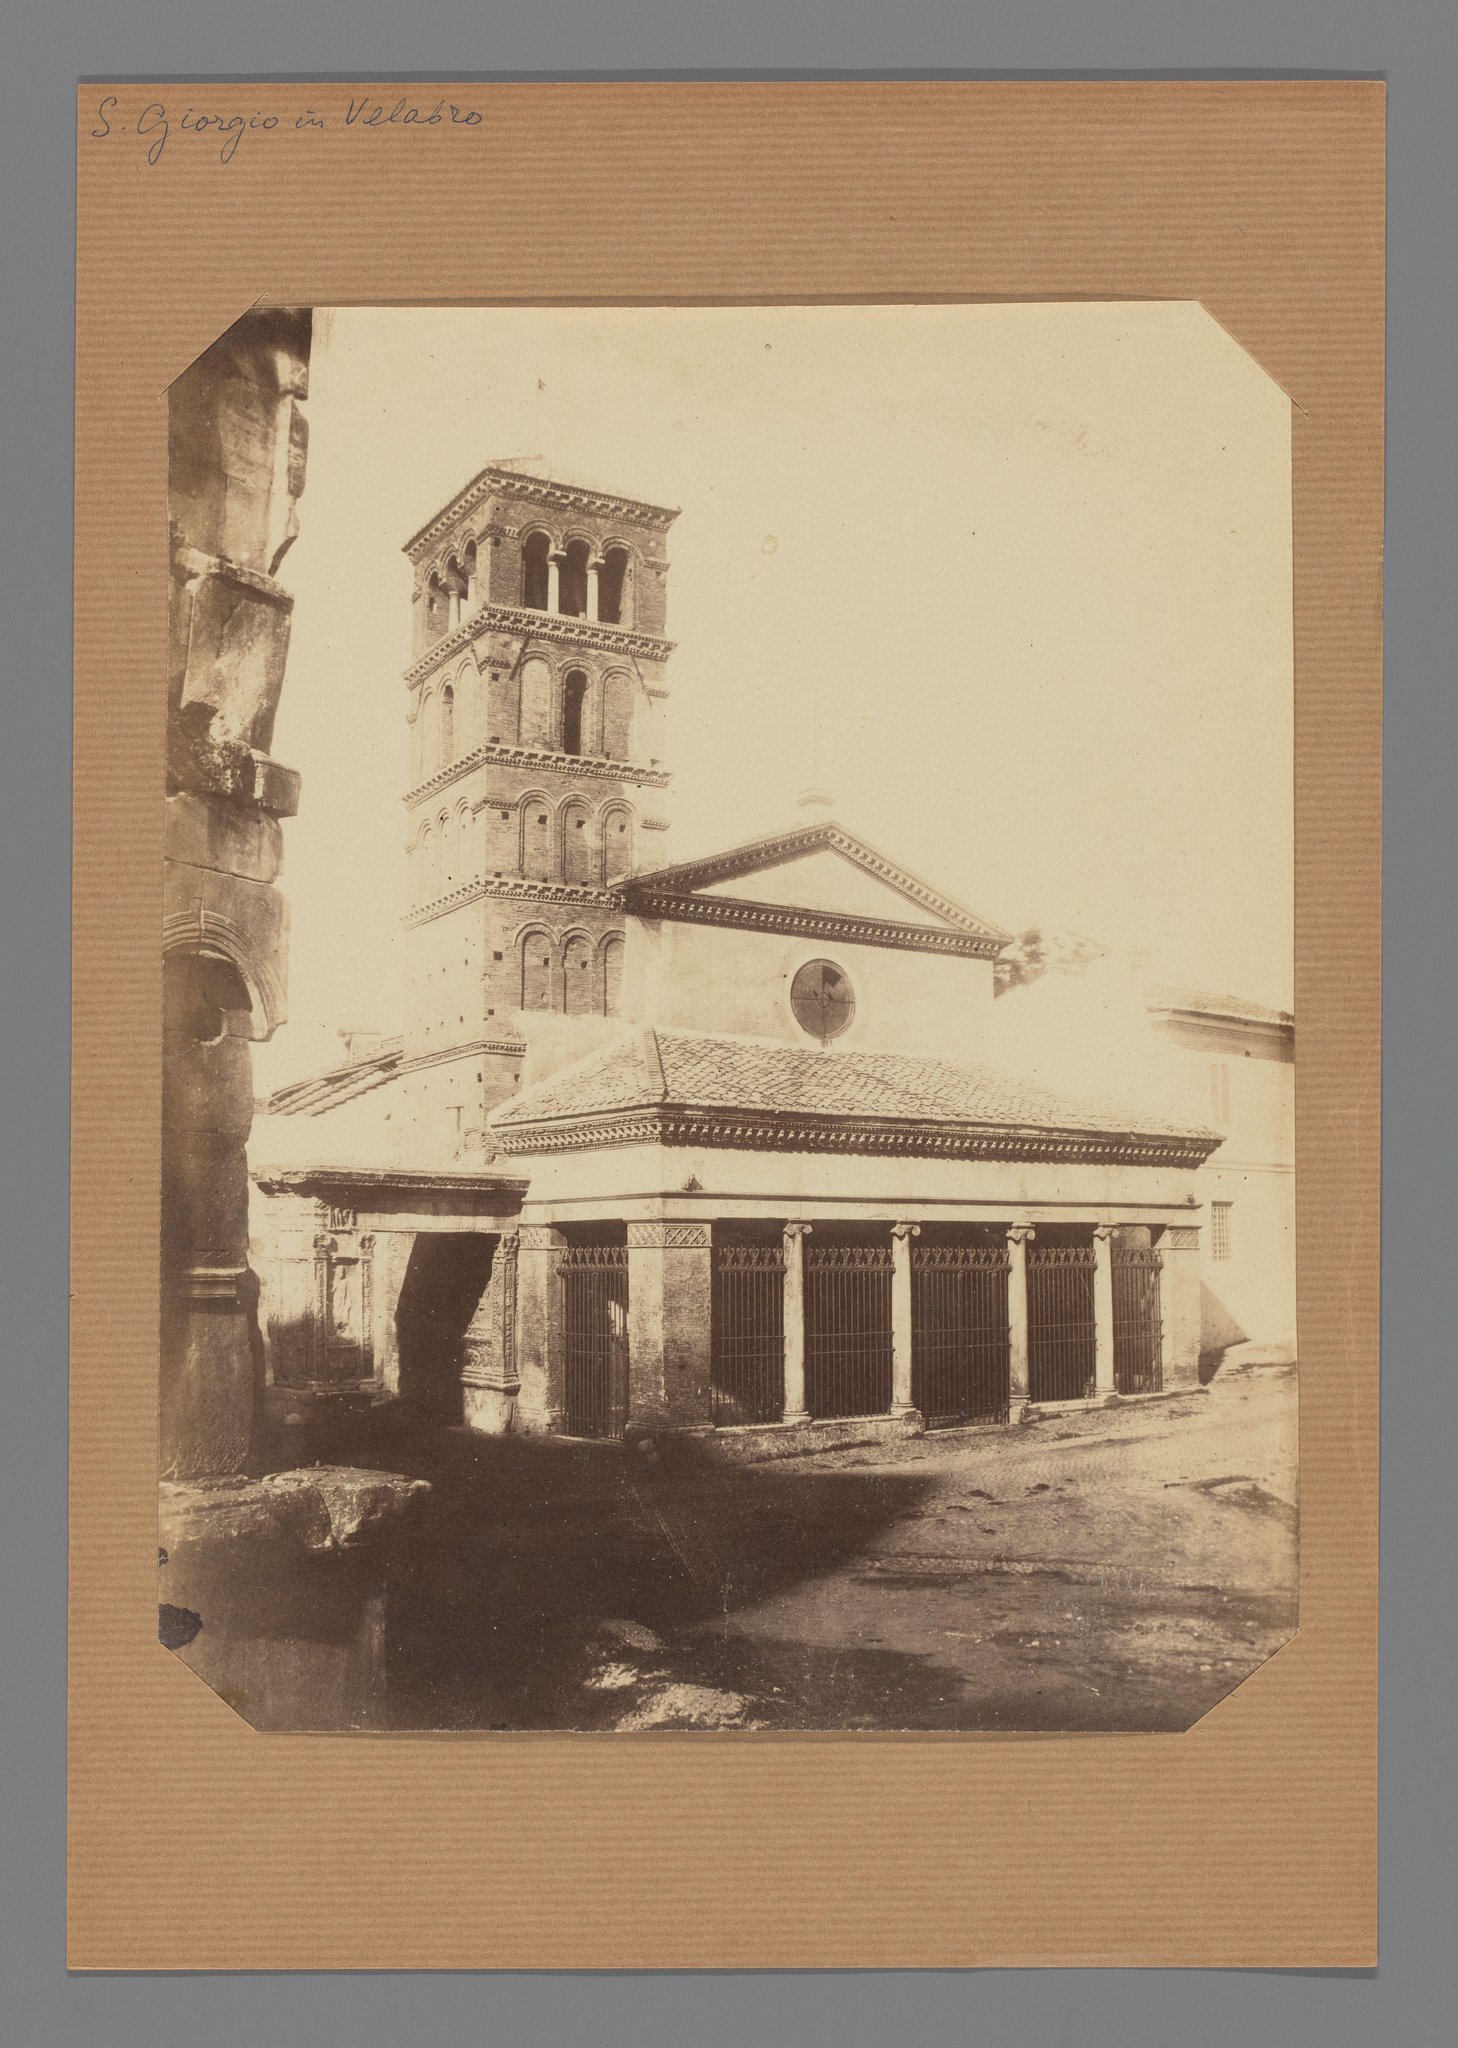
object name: photograph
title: S. Giorgio in Velabro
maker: Anonymous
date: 1850-1899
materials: paper, photographic support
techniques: albumen print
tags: san giorgio in velabro